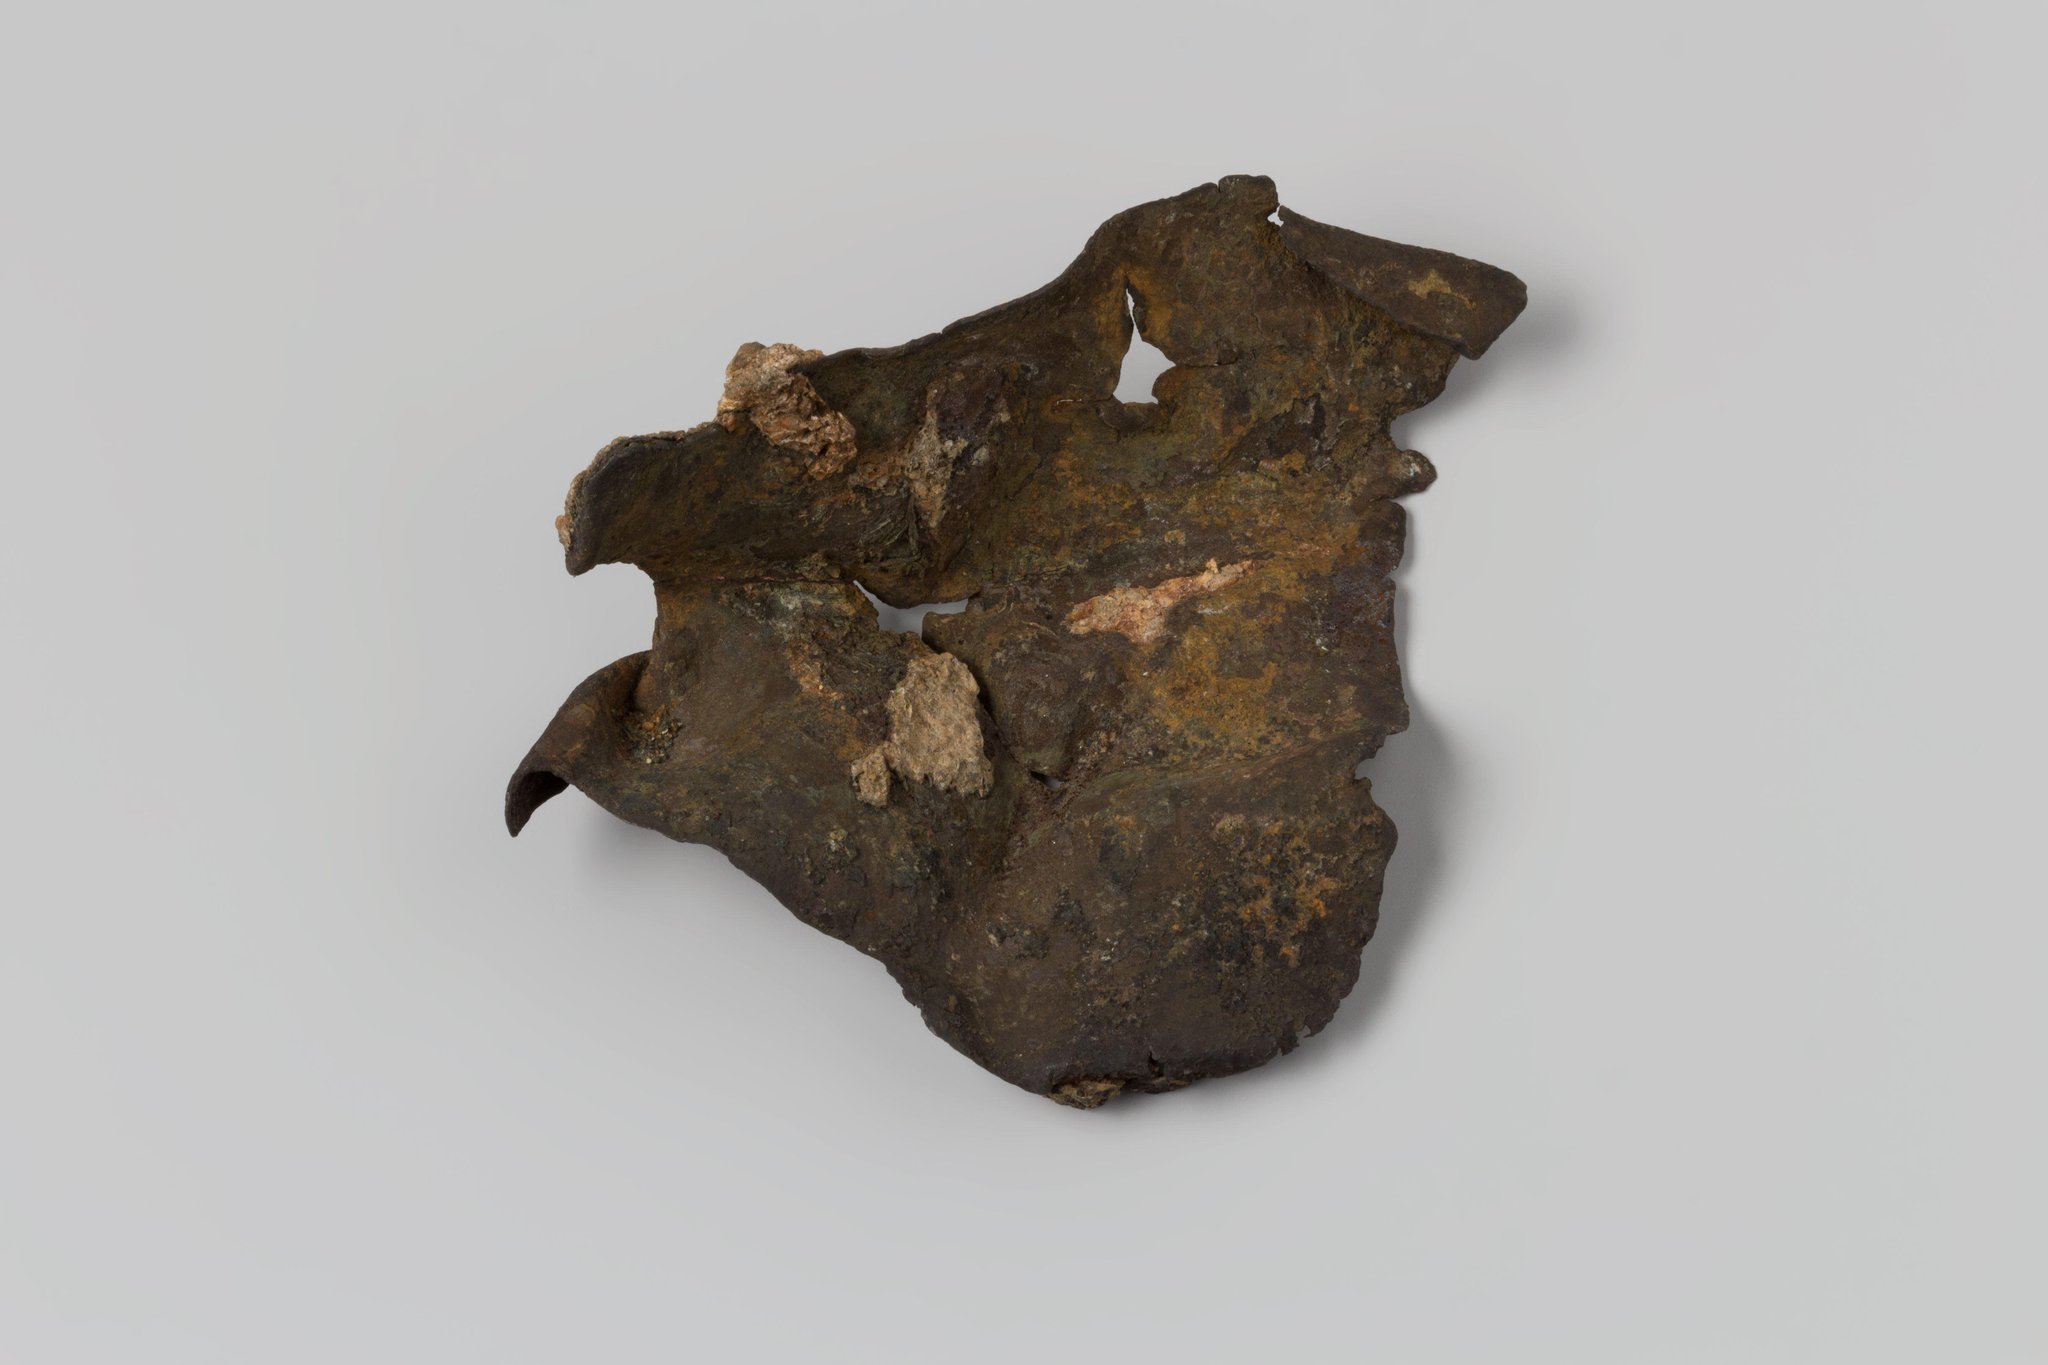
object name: scheepswrakvondst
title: Fragment van koper uit het wrak van de Oost-Indiëvaarder Hollandia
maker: Anonymous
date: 1700-1743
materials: copper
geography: netherlands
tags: verenigde oostindische compagnie, hollandia (schip), annet